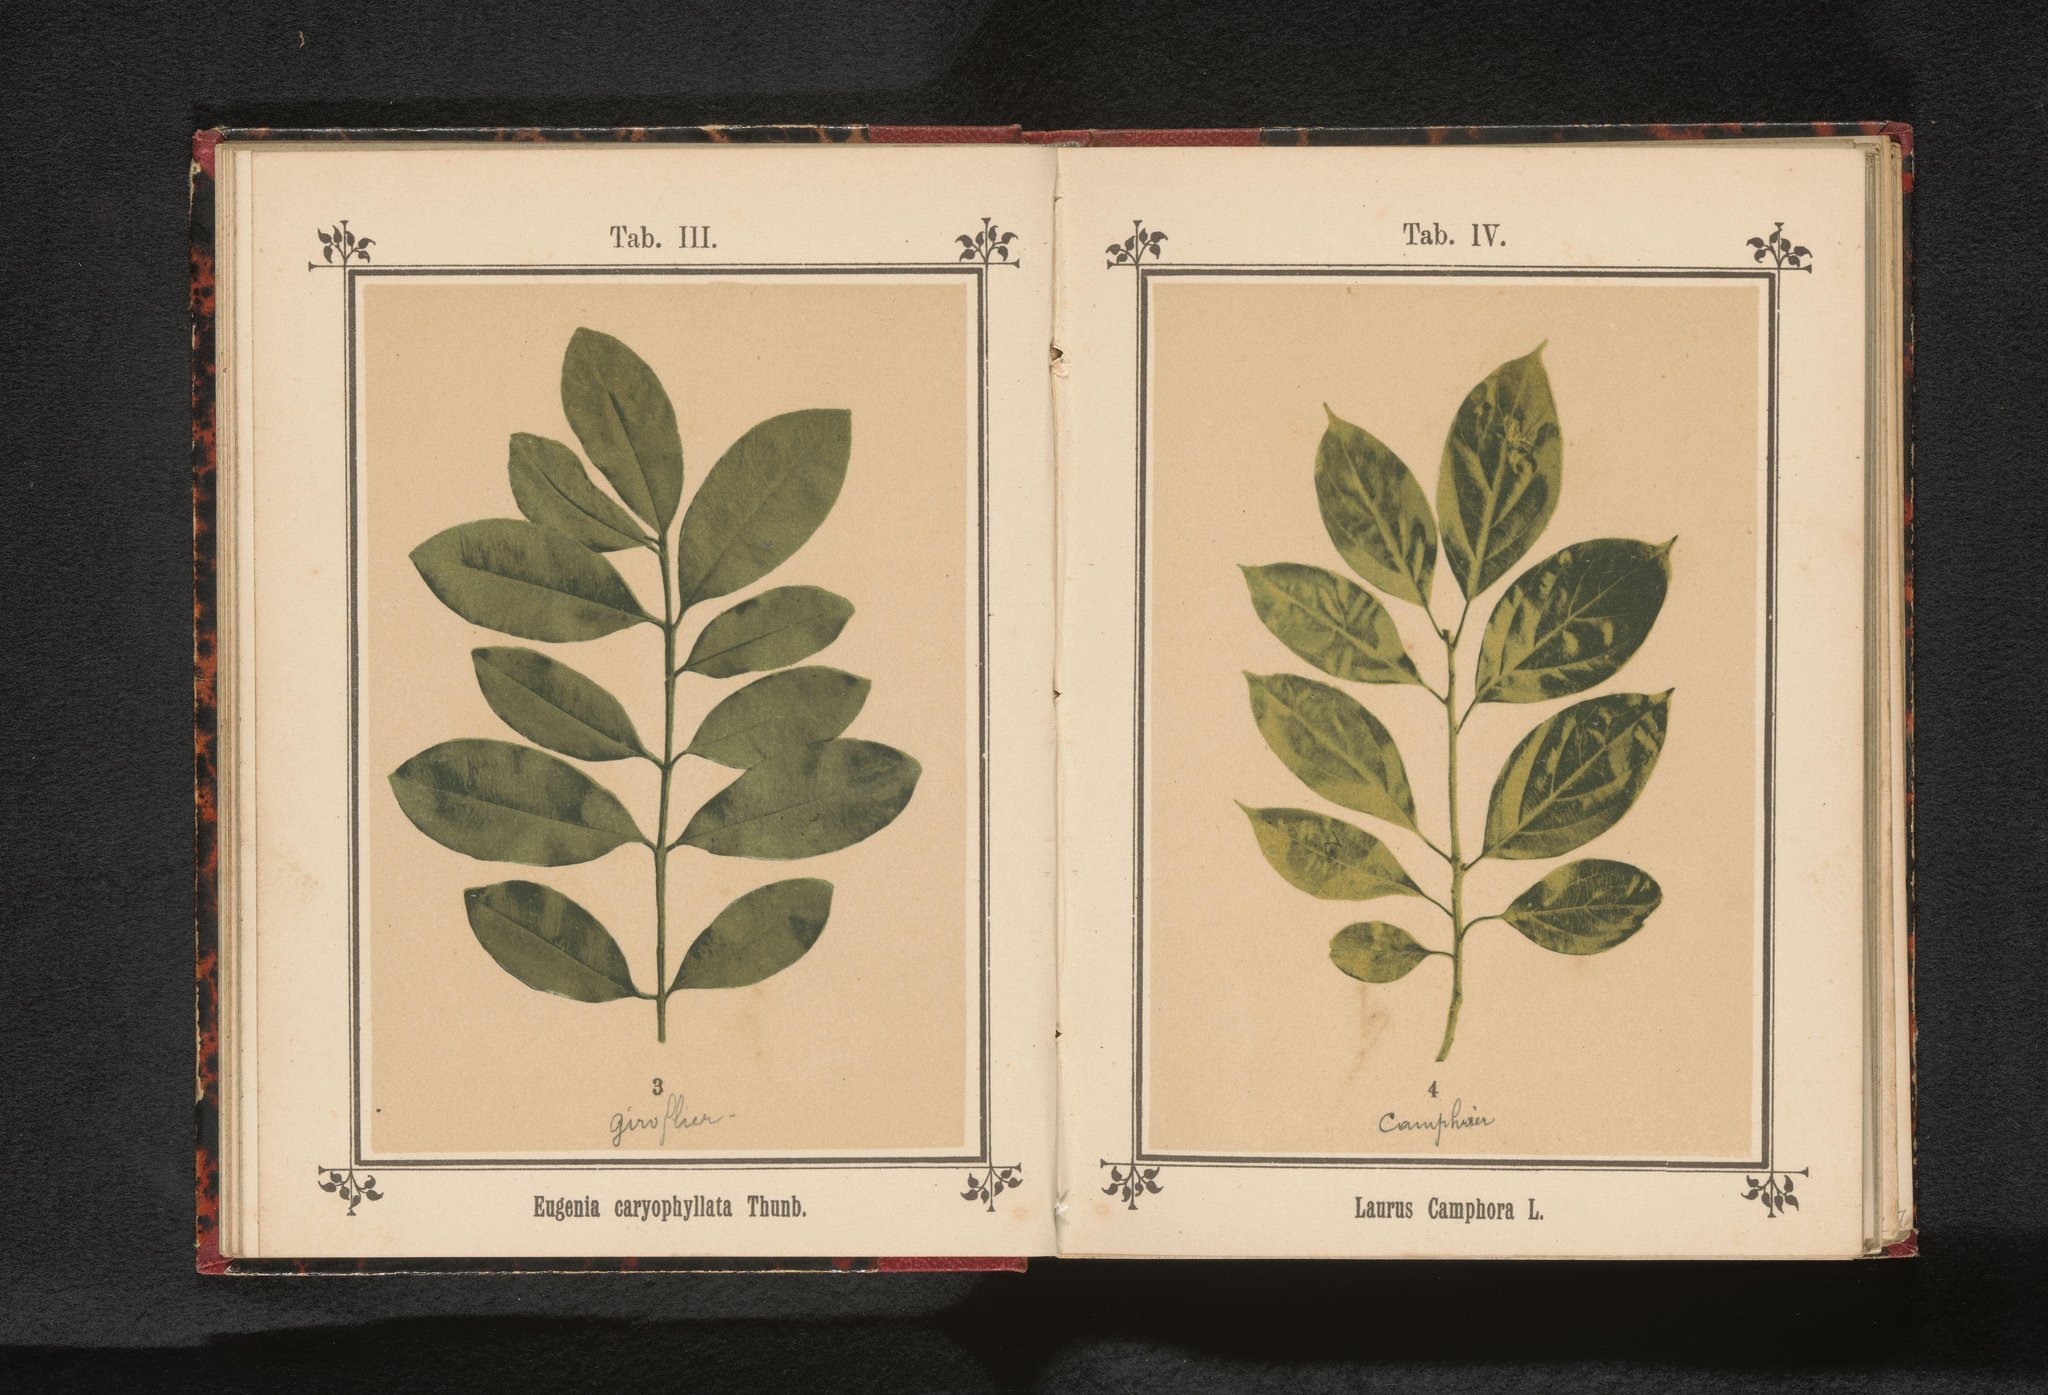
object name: page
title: Tak van een kamferboom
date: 1884-1894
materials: paper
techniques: photograph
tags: trees (+ branch, stick)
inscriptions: number: ‘Tab. IV.’, inscription: ‘camphère’